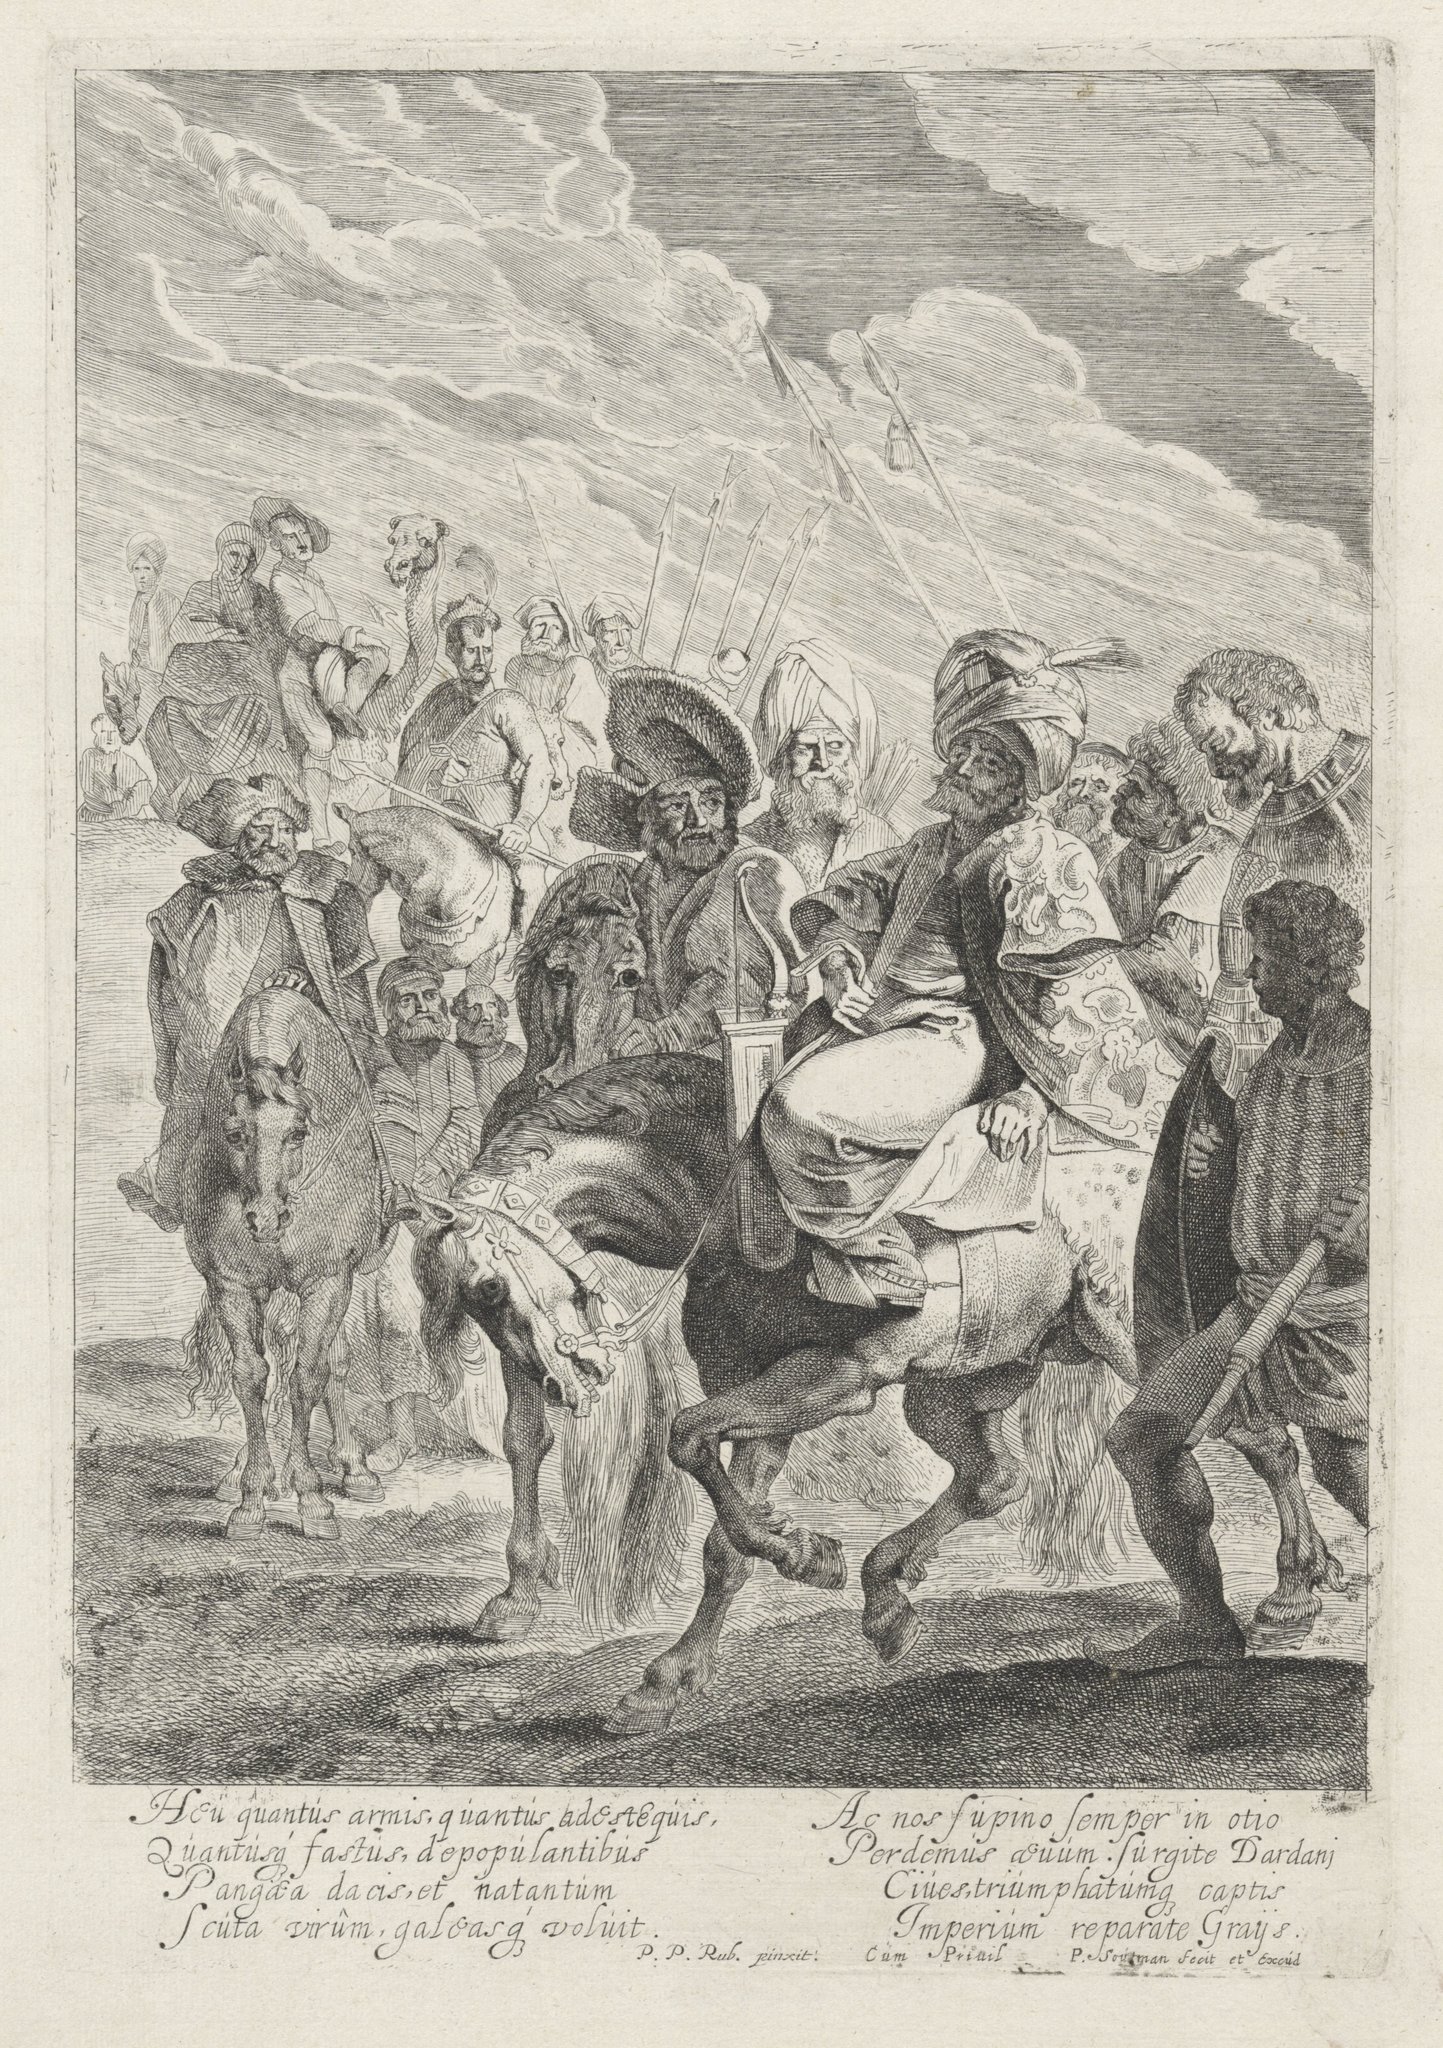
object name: print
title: Turkse prins te paard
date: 1616-1657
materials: paper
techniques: engraving, etching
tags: hoofed animals: camel, asiatic races and peoples: turks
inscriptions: collector's mark: Lugt 240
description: Een Oosters geklede man zit op een paard. Voor hem op het paard een koker waarin hij zijn boog vervoert. Om hem heen zijn gevolg, te voet en te paard. Op de achtergrond een man en een vrouw op een kameel. Onder de afbeelding acht versregels in het Latijn.